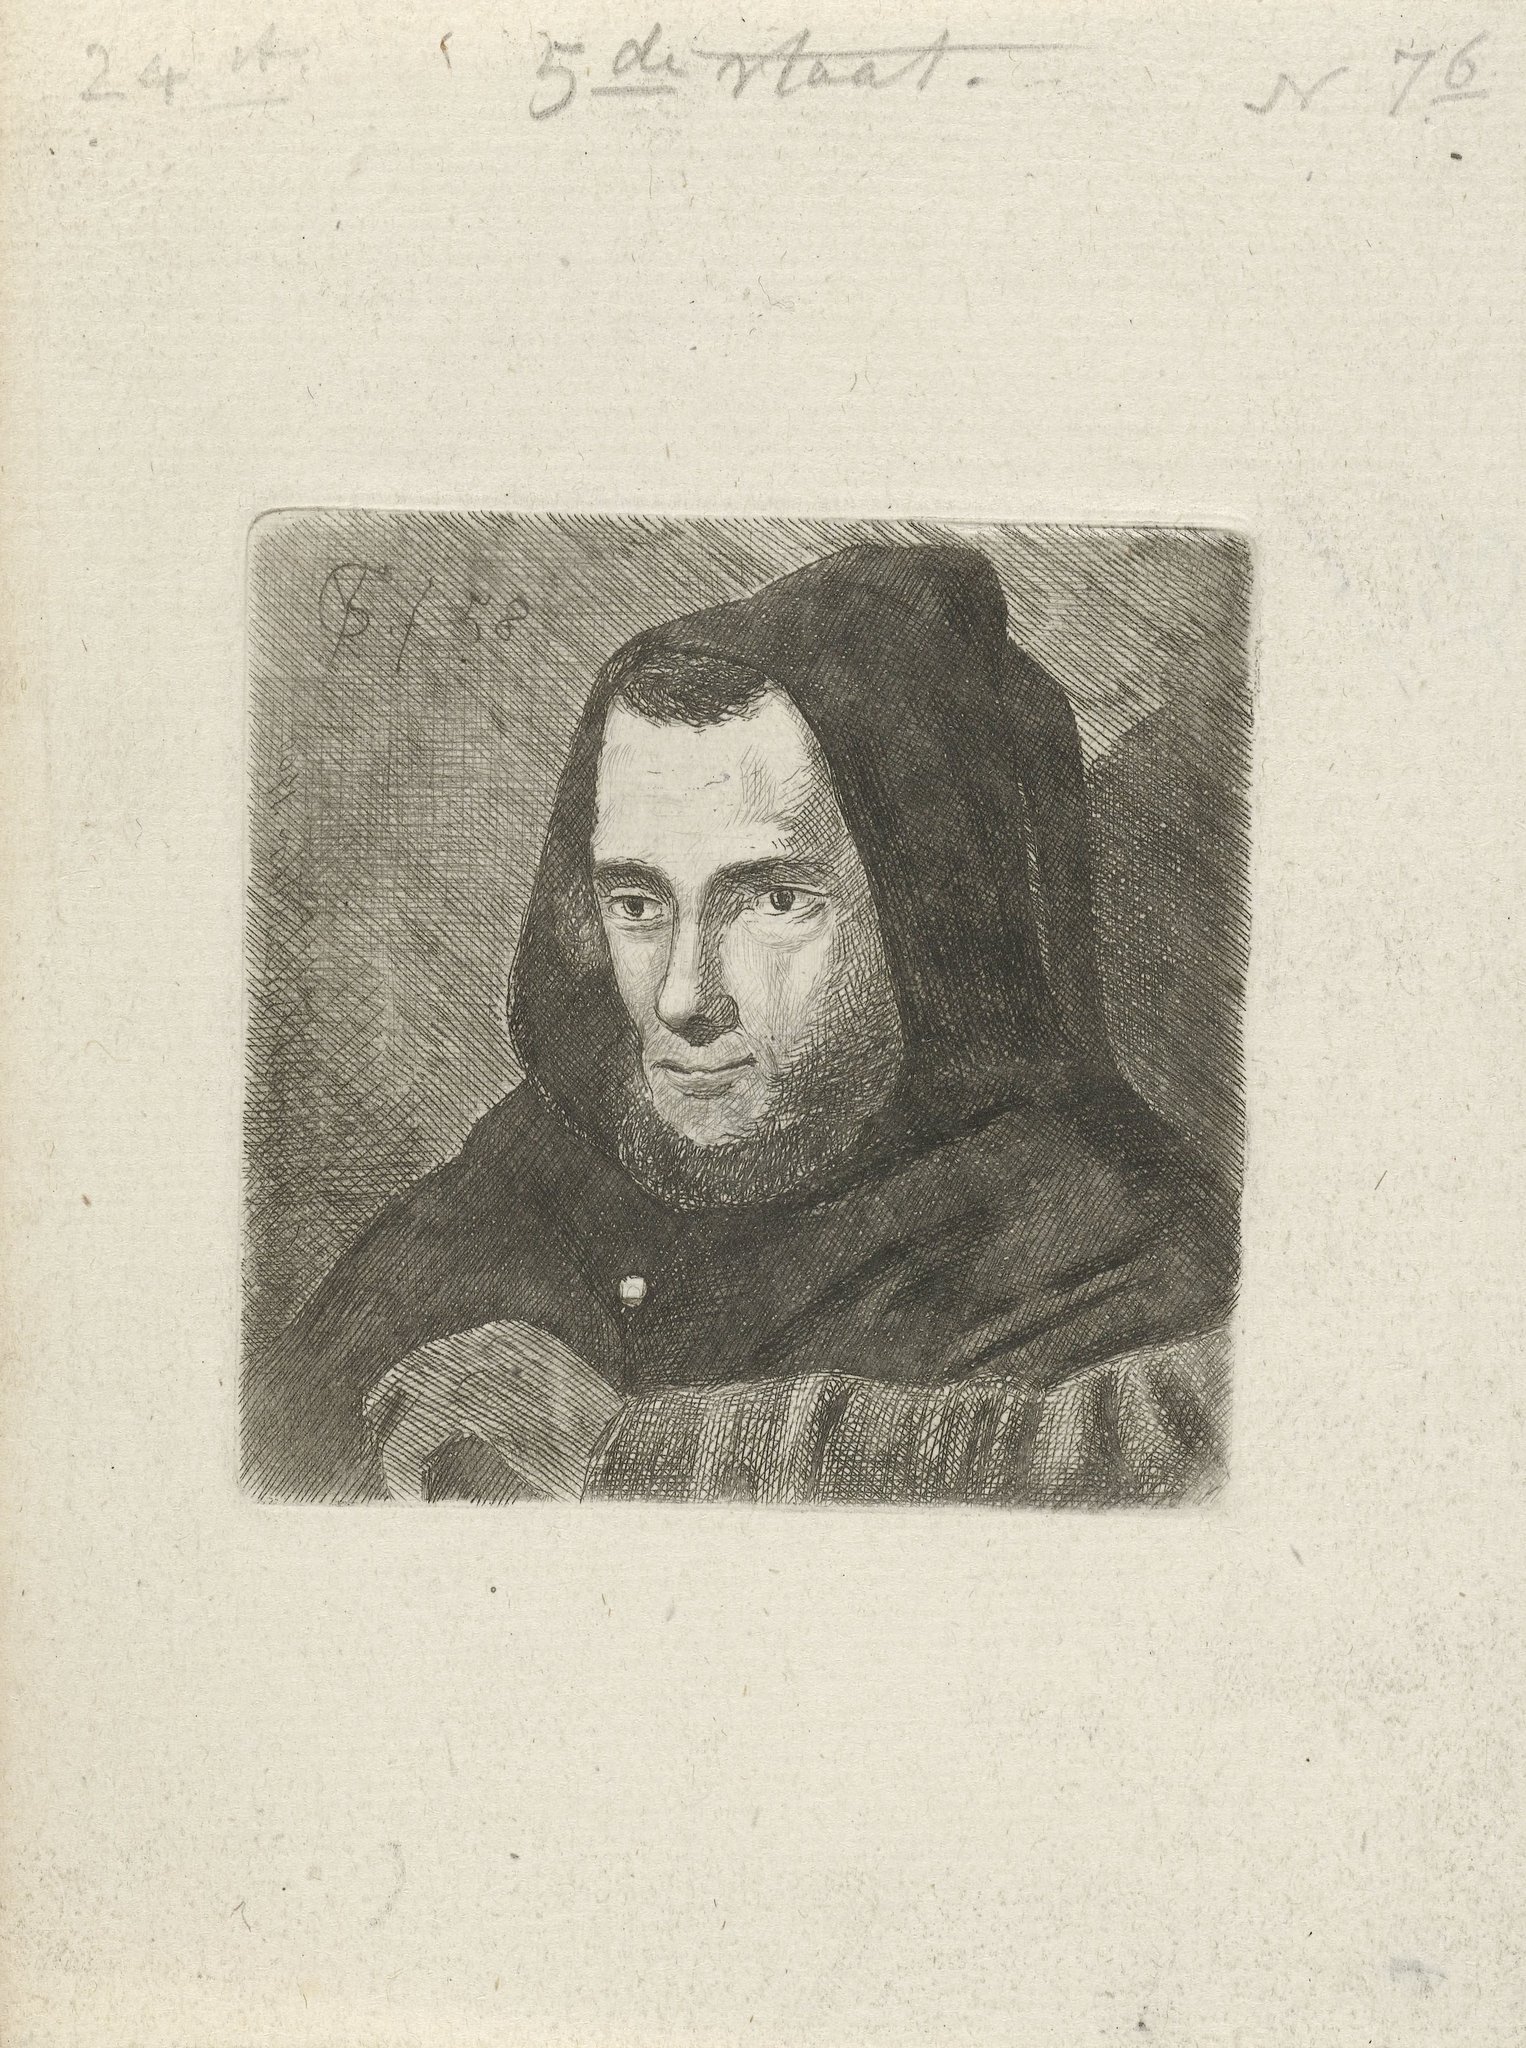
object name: print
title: Opperjagermeester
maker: cornelis van der griendt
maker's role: draughtsman, painter, print maker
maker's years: 1827-1918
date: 1858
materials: paper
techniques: drypoint, etching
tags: monk(s), friar(s), adult man (+ front view)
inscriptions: collector's mark: Lugt 2228